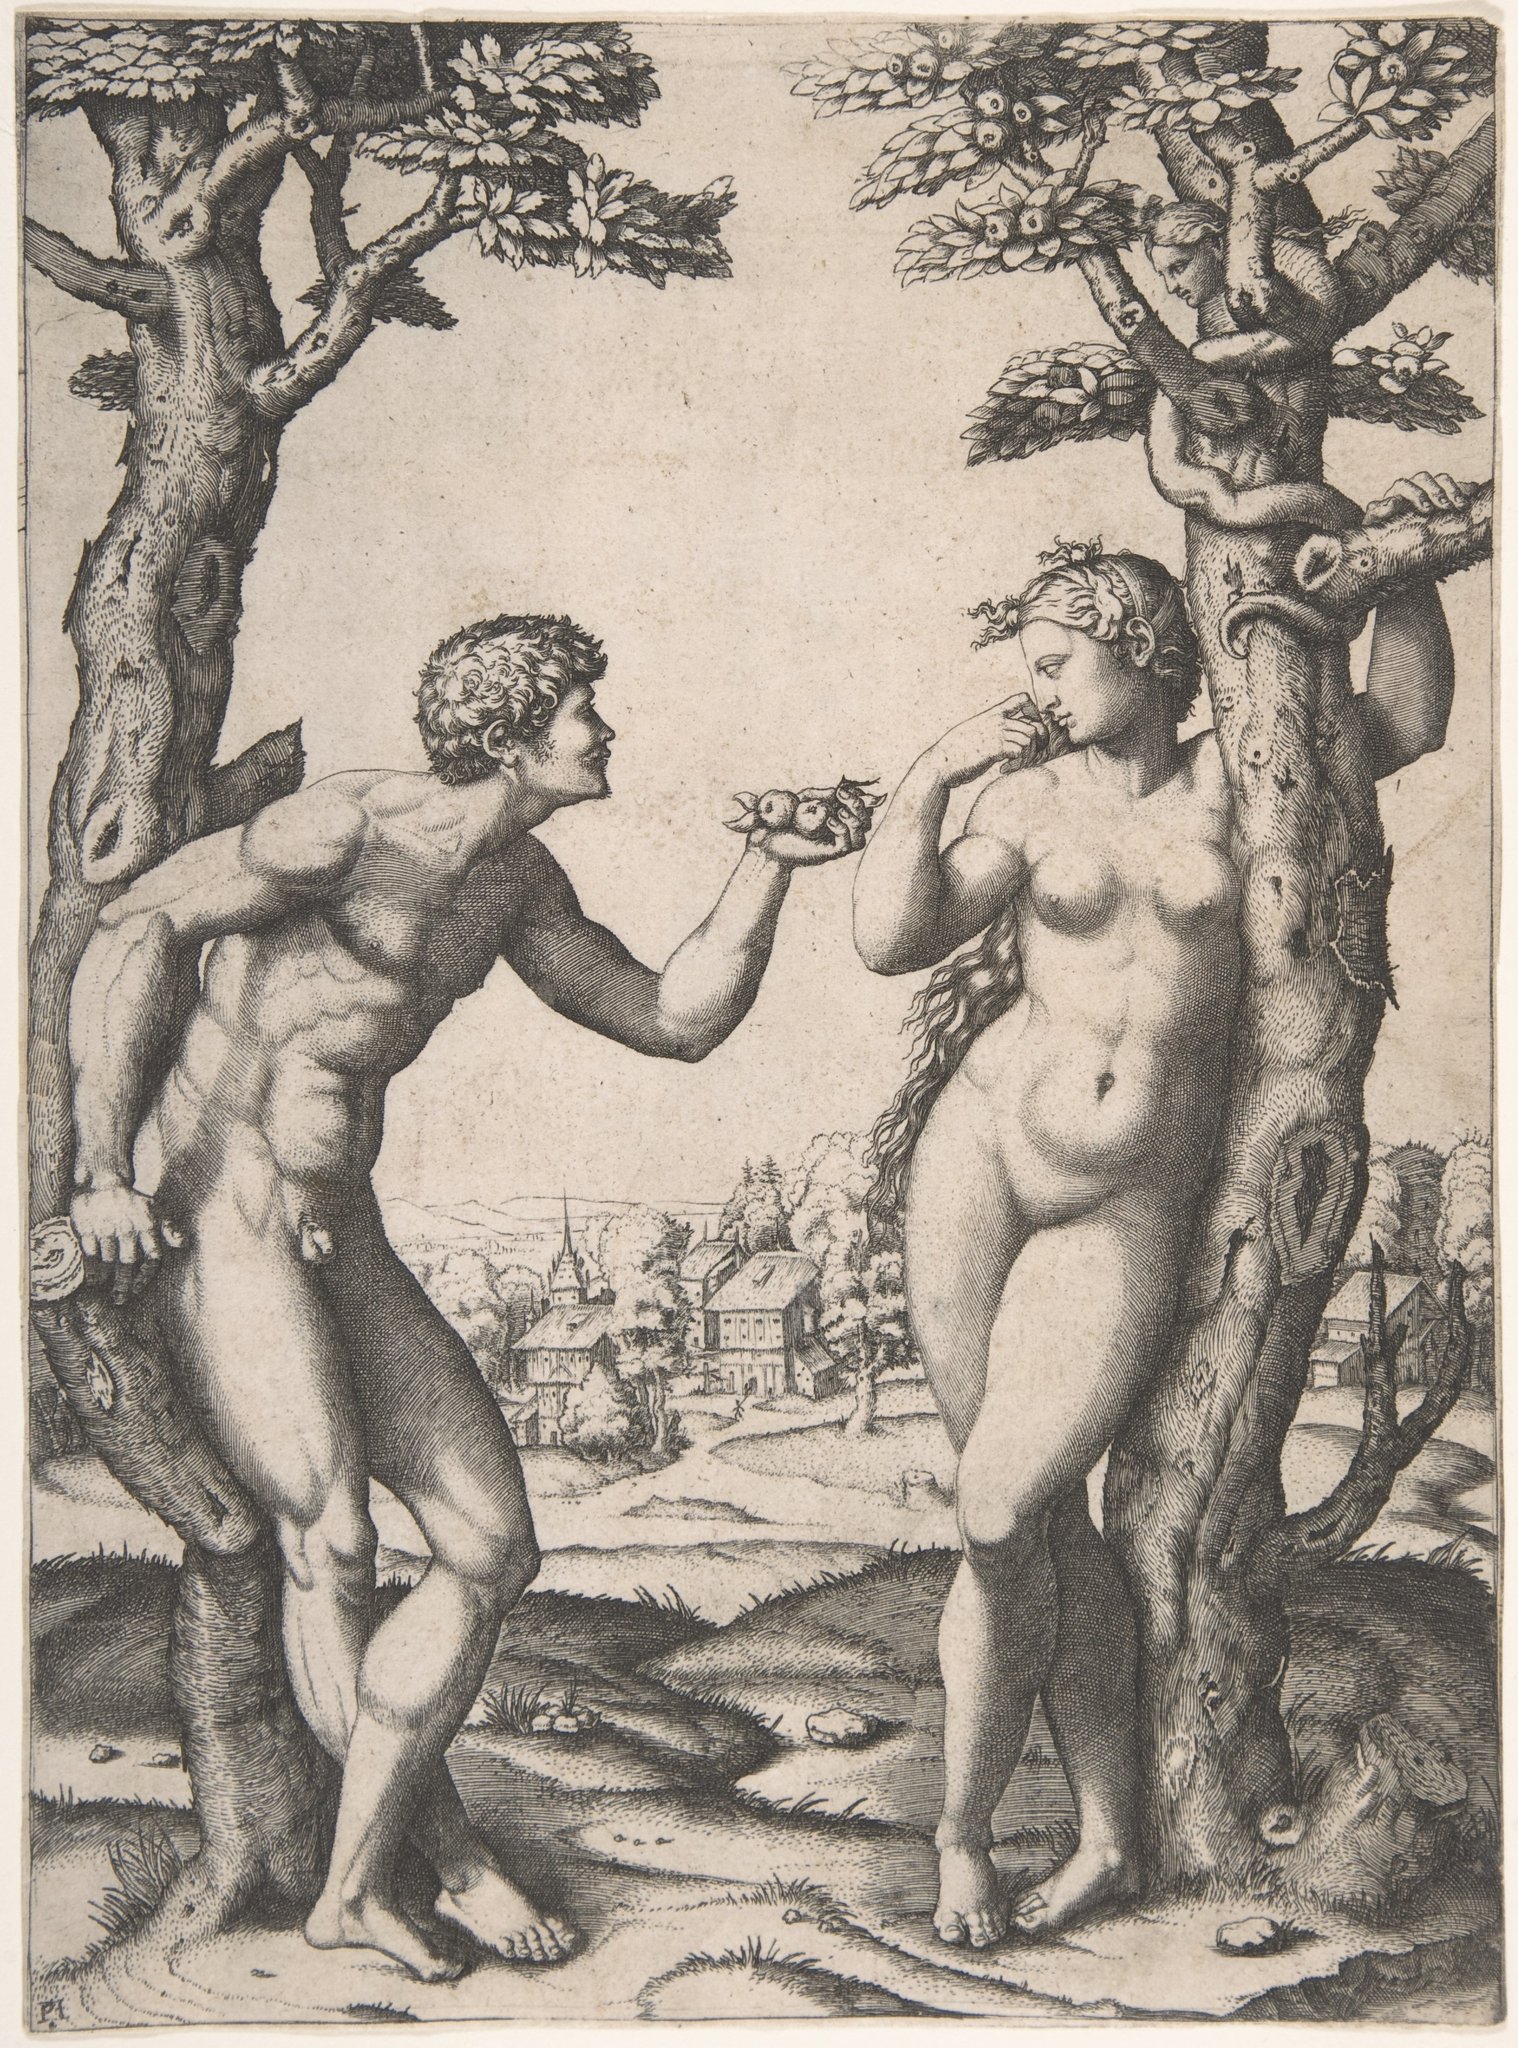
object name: print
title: Adam and Eve flanked by two trees, a town in the background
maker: marcantonio raimondi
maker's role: artist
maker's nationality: italian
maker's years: 1475-1534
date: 1512-1514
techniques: engraving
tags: men,women,serpents,trees,adam,eve